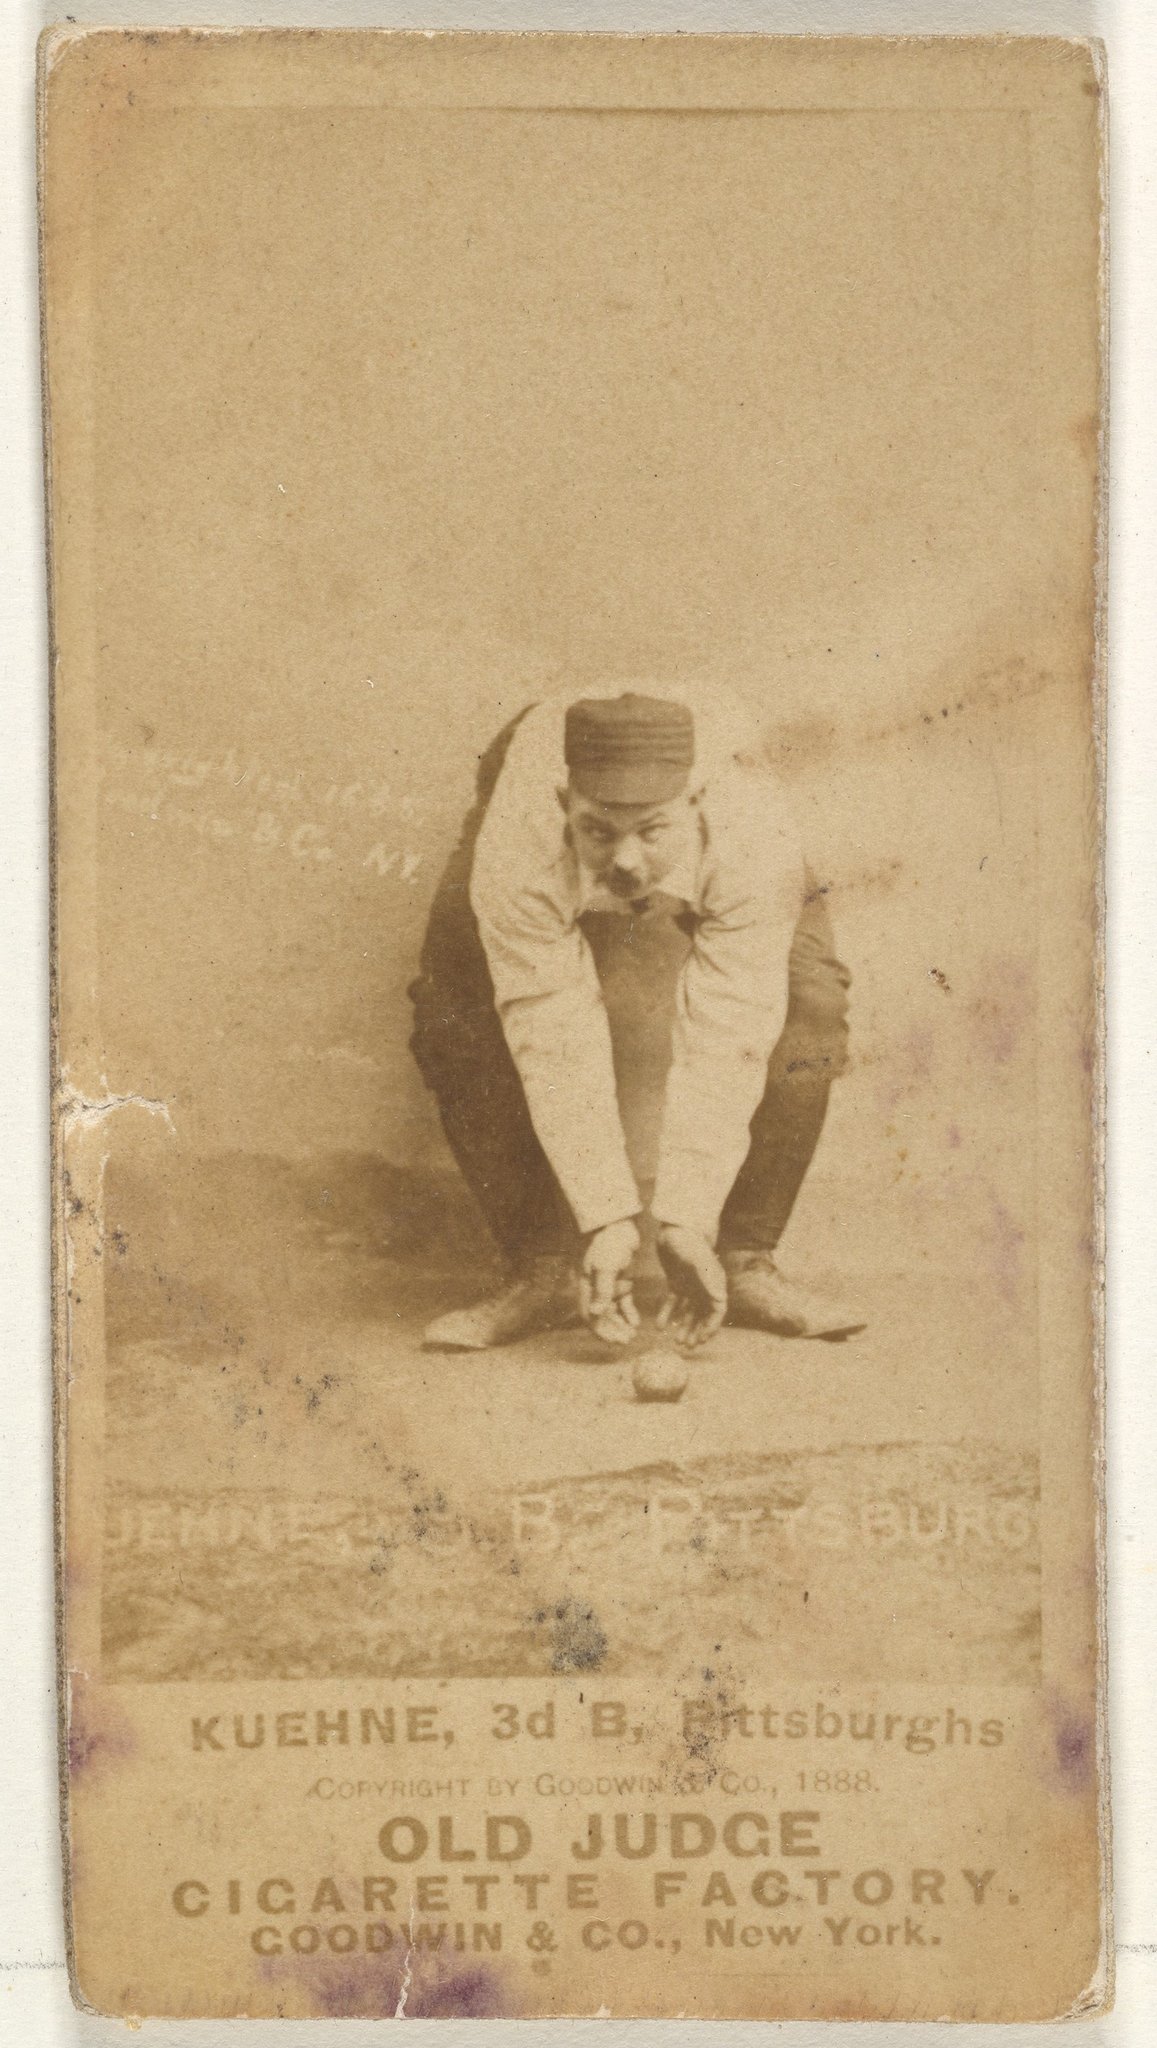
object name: baseball card, photograph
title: Bill Kuehne, 3rd Base, Pittsburgh, from the Old Judge series (N172) for Old Judge Cigarettes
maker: goodwin & company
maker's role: publisher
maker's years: 1850-1950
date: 1888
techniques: albumen silver print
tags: men,portraits,baseball,athletes